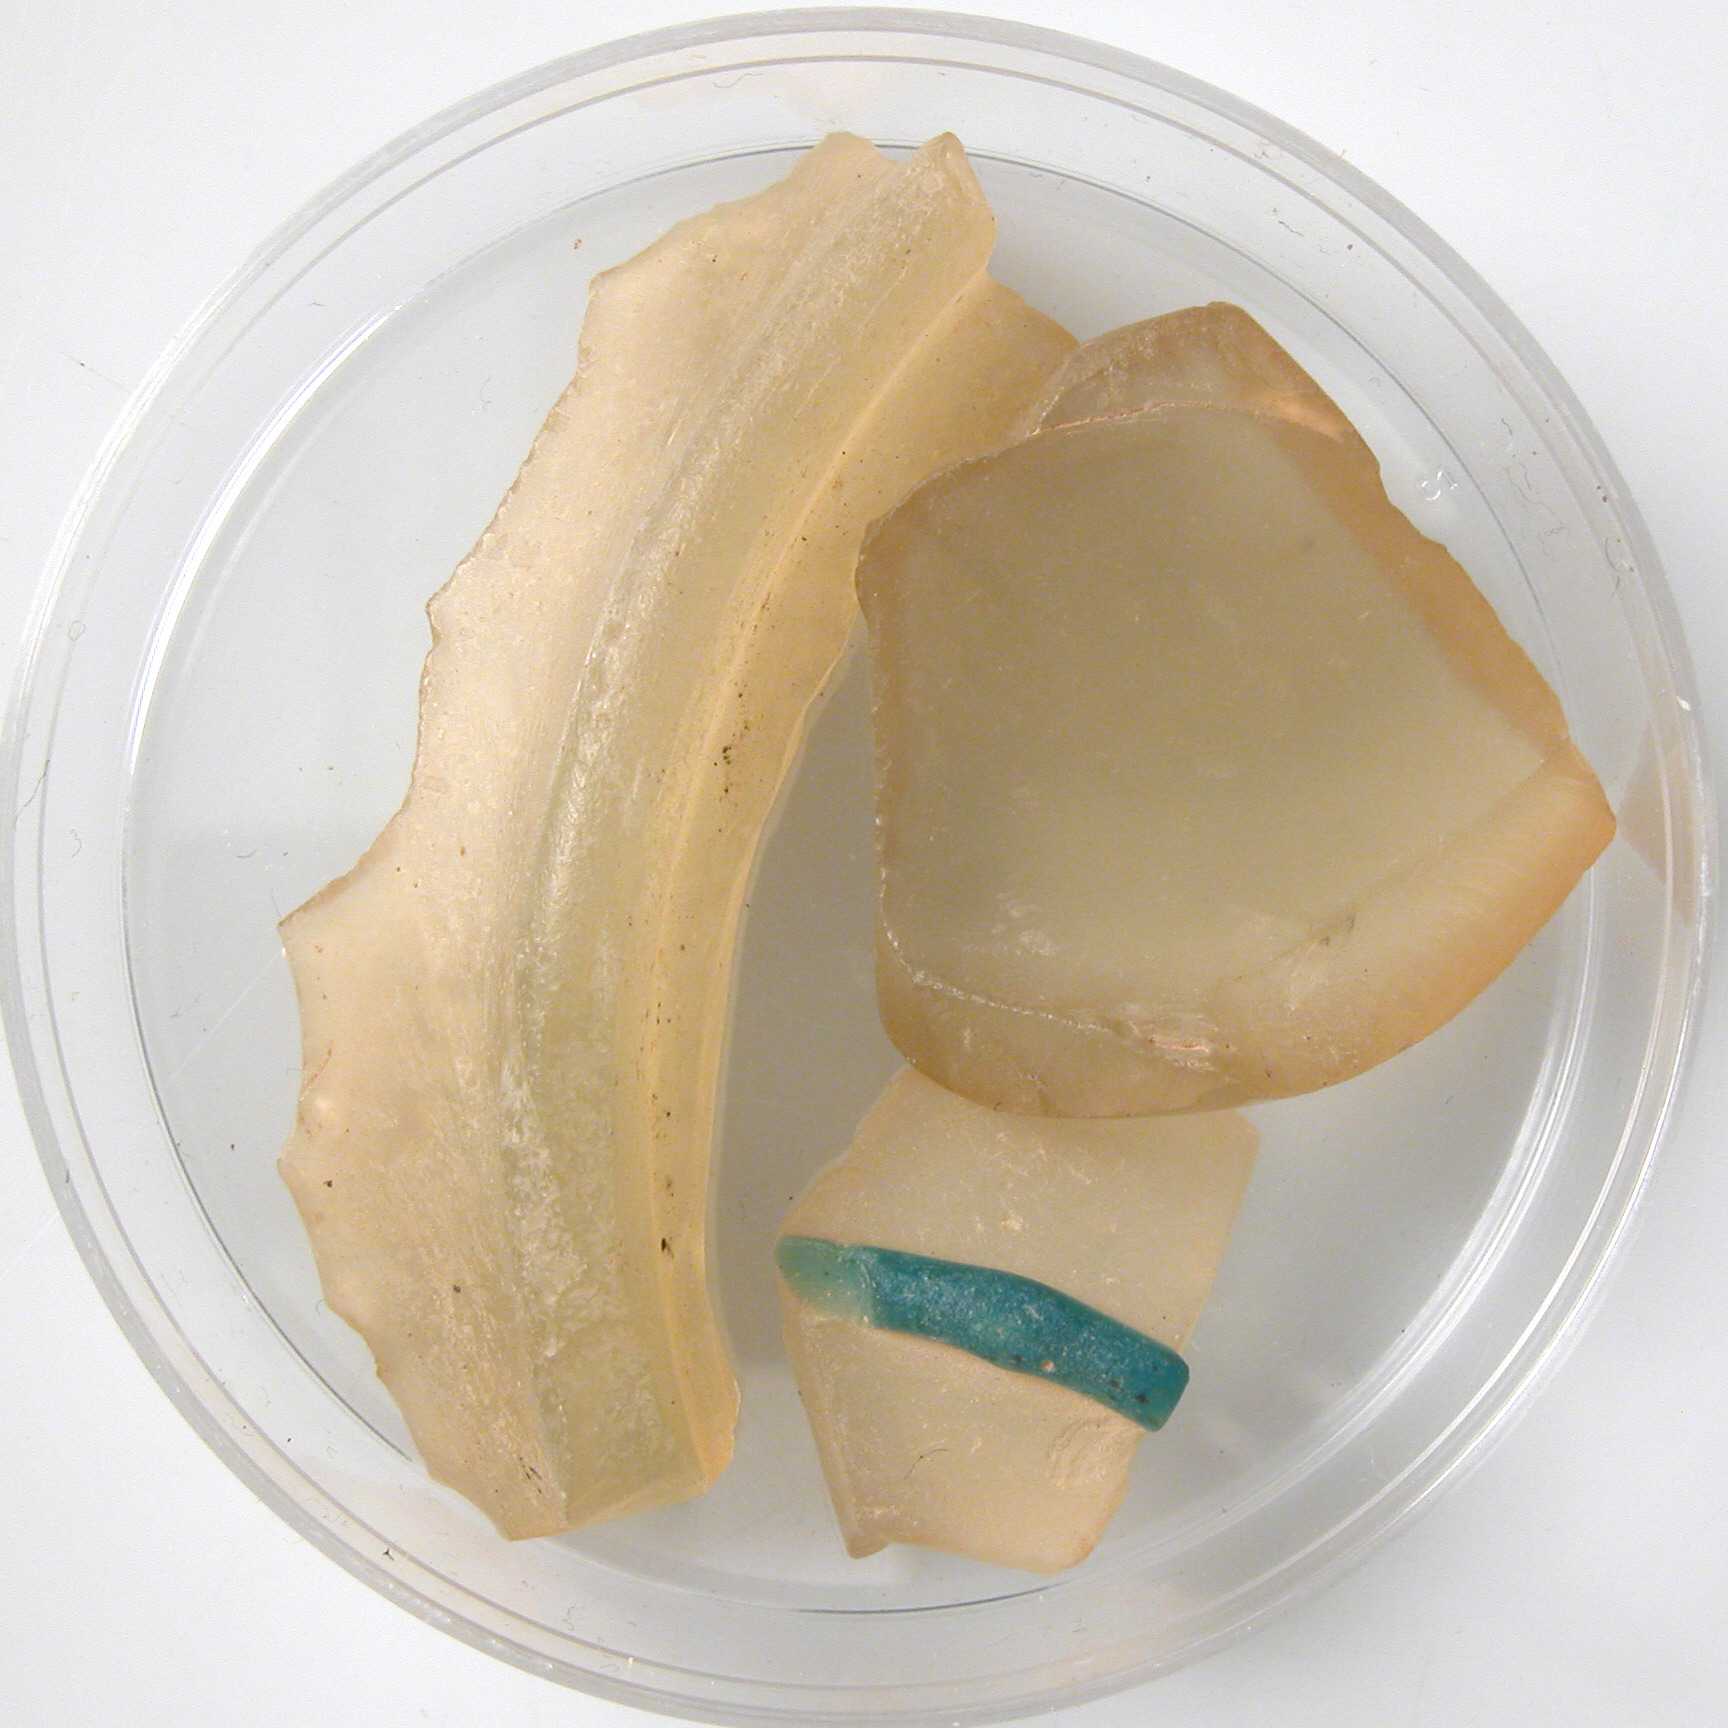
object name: fragment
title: Glass Fragments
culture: coptic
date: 301-700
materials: glass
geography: egypt